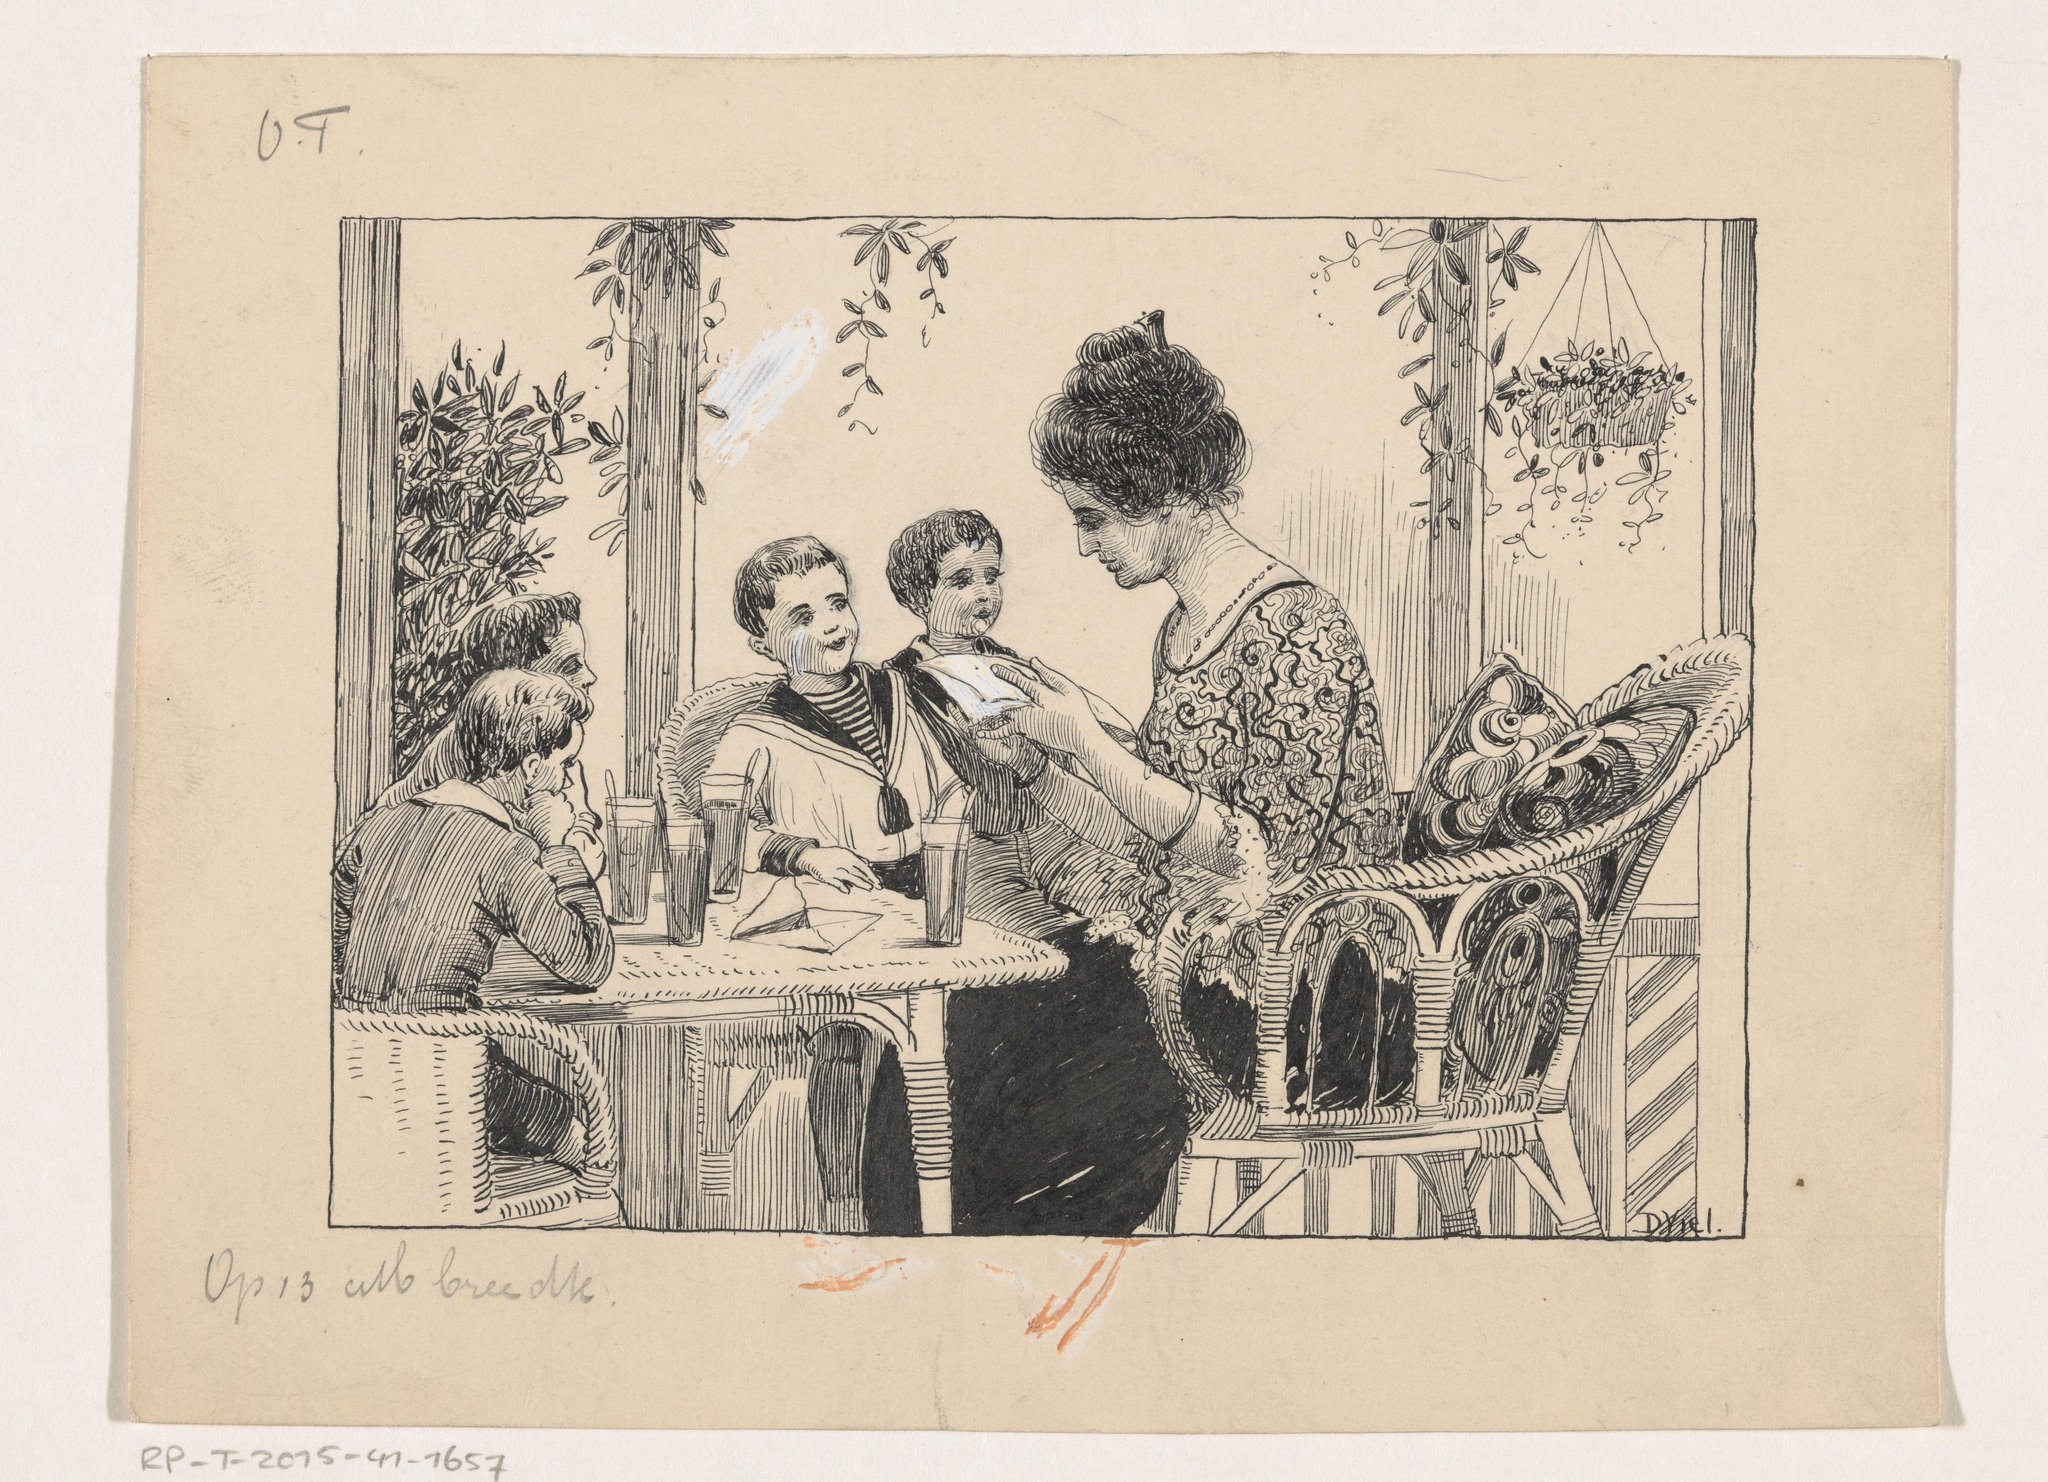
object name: boekillustratie ontwerp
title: Vrouw leest een brief in een serre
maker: d. viel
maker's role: draughtsman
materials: paint, ink, paper, pencil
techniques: brush, pen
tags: sun-porch, sun-parlour, glazed verandah, letter, envelope, mother and child(ren), woman and child(ren) (family group)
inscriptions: collector's mark: Lugt 2228, :, signature: ‘D Viel.’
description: Ontwerp voor: Dietz, Henriette e.a. Kees zijn avontuur: vertellingen voor jongens en meisjes. Ons thuis-serie. Amsterdam: Veen, 1923.